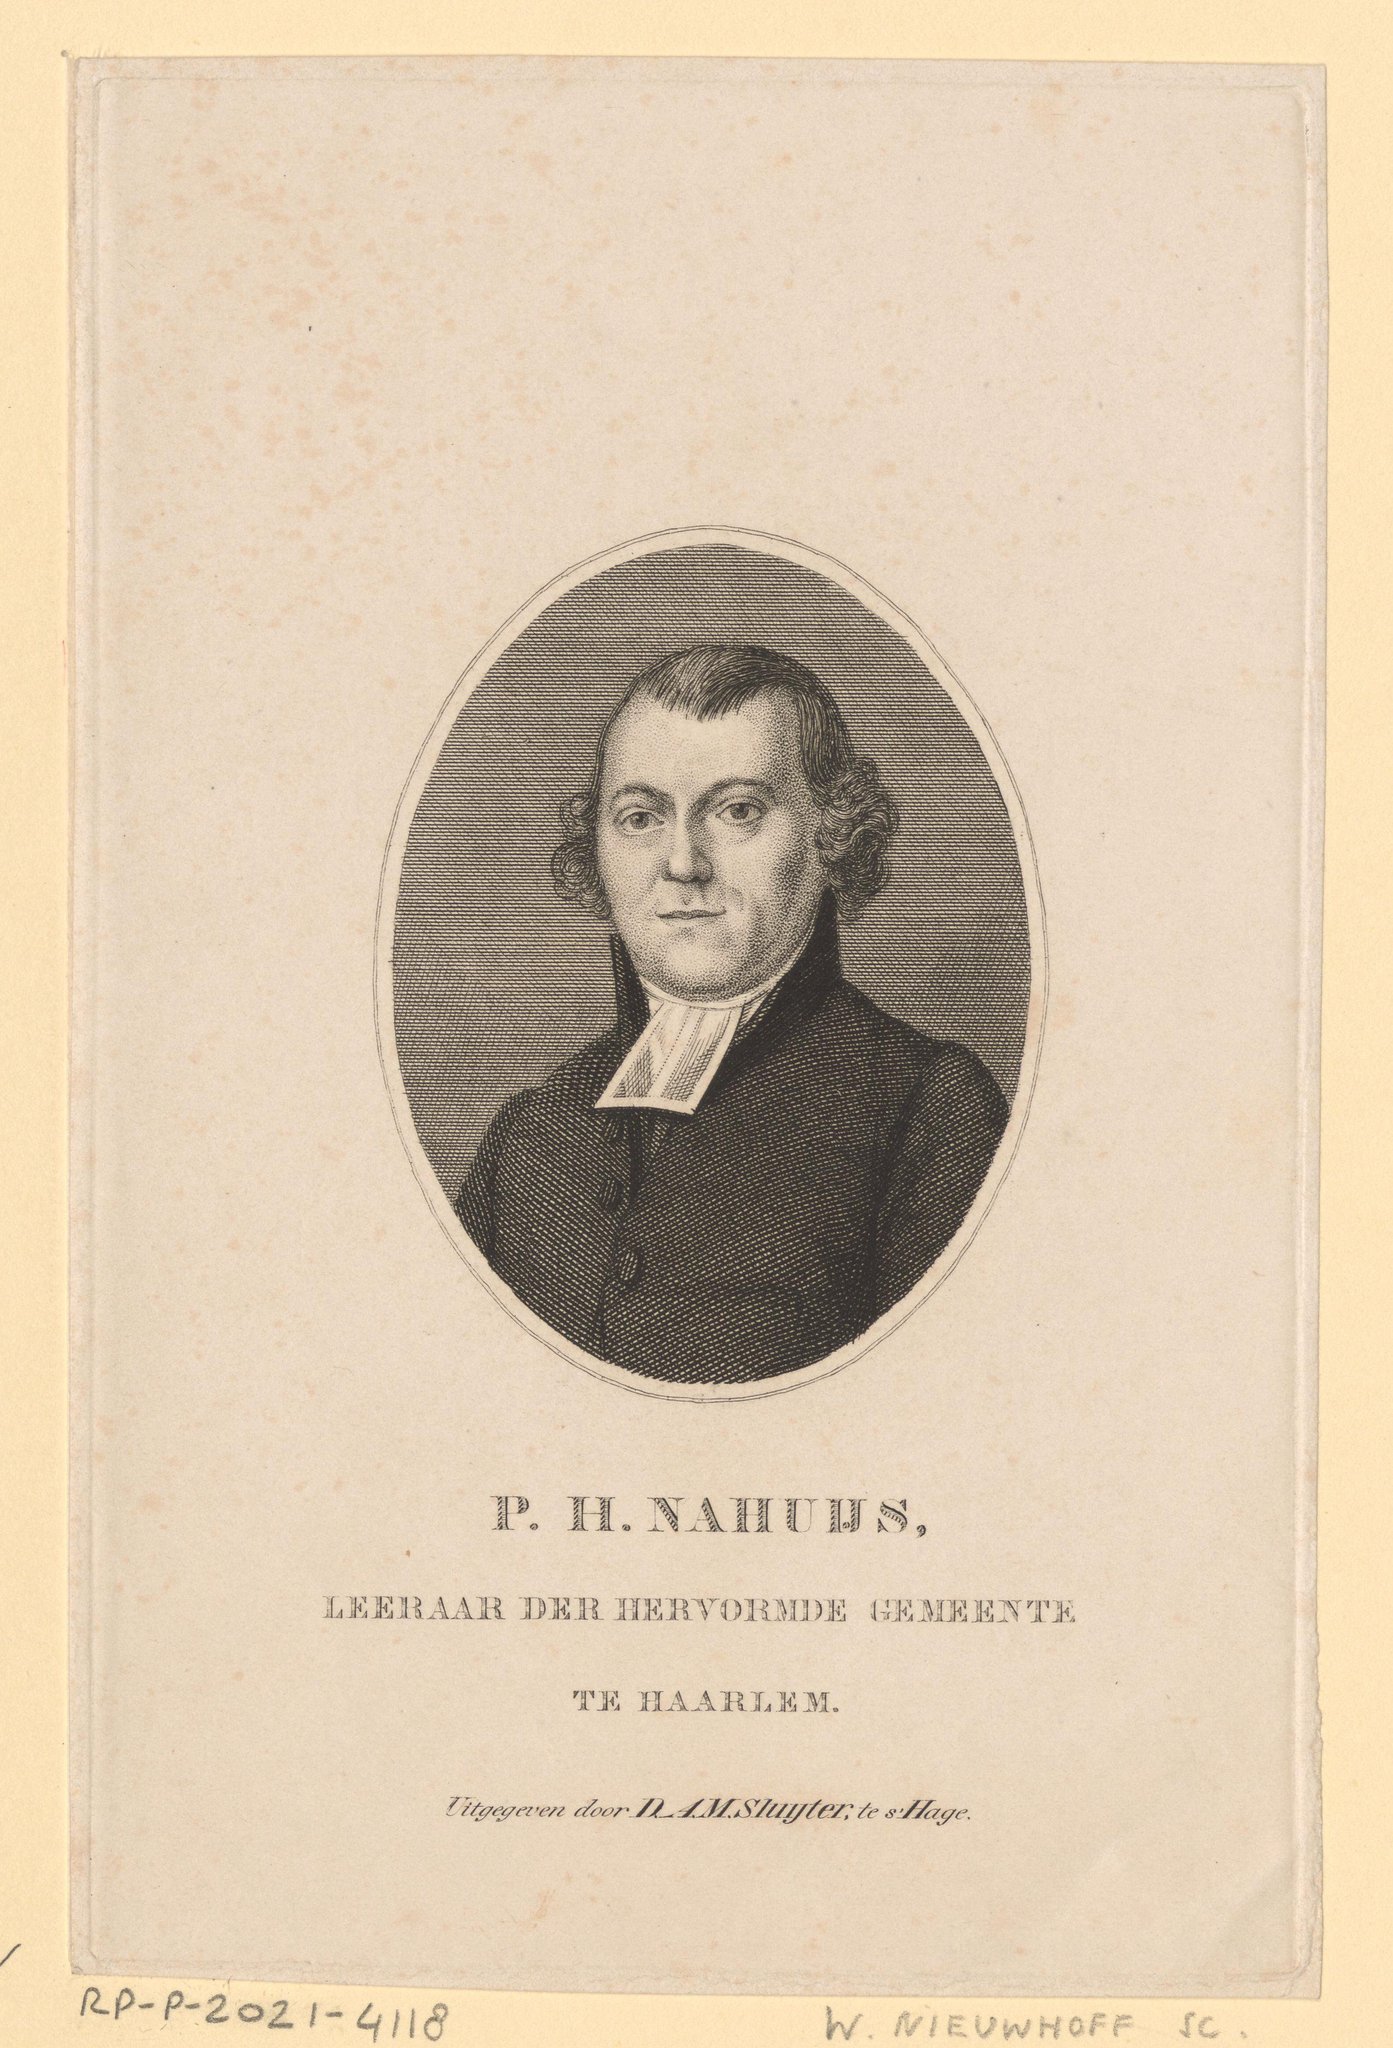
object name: print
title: Portret van Pieter Huibert Nahuys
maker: d.a.m. sluyter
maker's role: publisher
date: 1810-1837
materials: paper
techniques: engraving, etching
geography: the hague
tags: protestant churches and denominations, historical persons